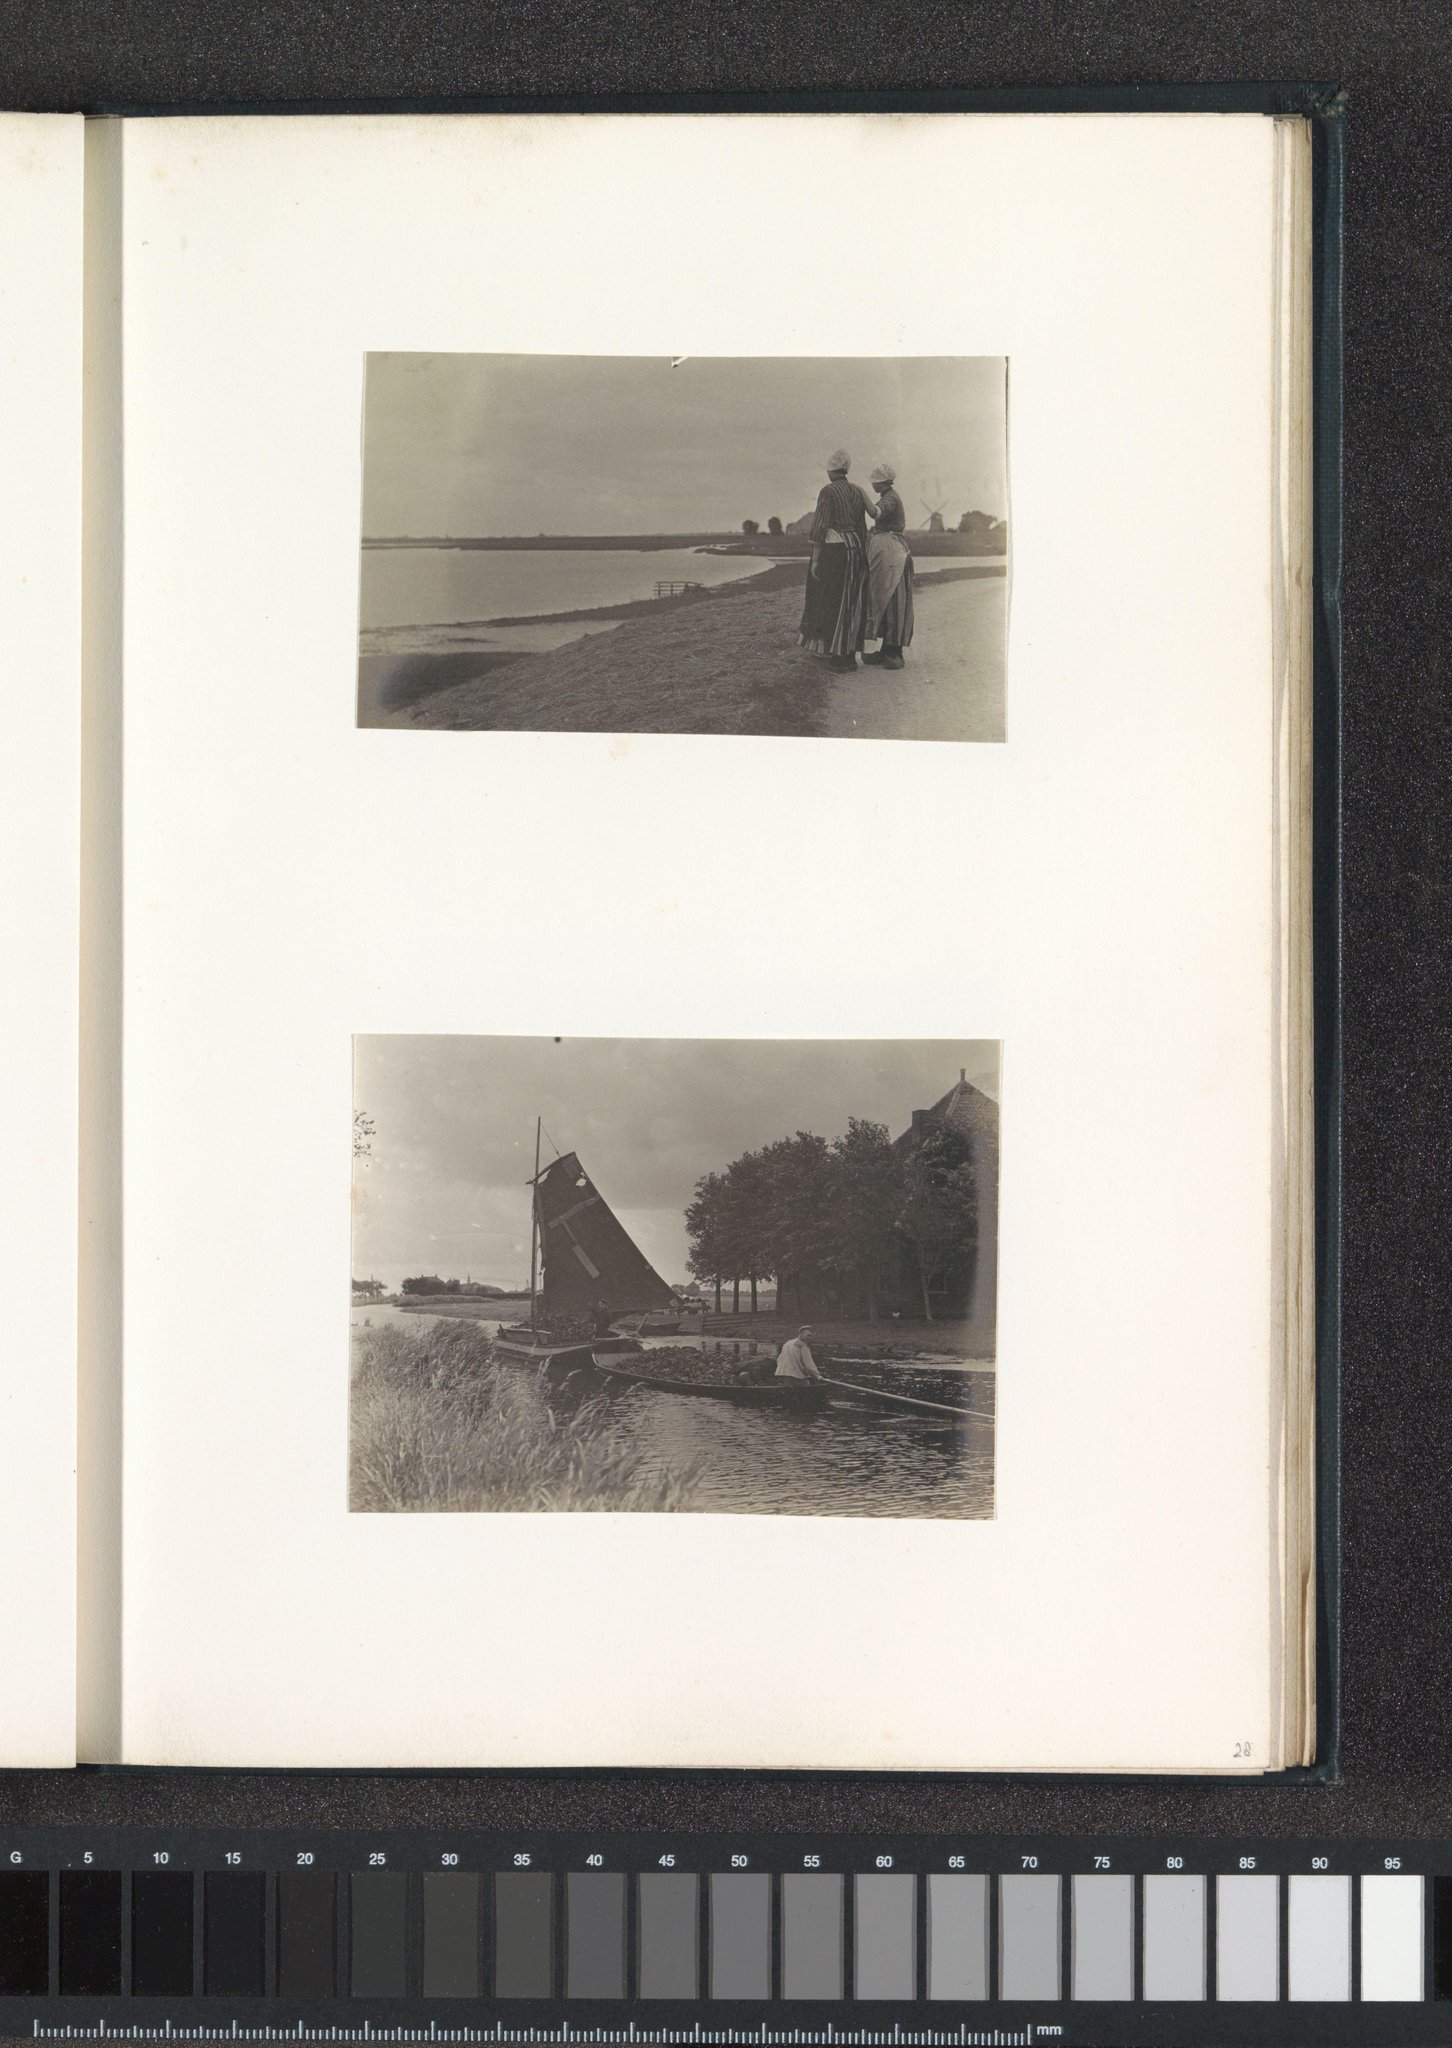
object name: photograph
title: Twee vrouwen in Volendamse klederdracht staand op een dijk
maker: george hidderley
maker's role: fotograaf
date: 1900-1910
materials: paper, photographic support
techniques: gelatin silver print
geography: volendam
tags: folk costume, regional costume (+ women's clothes), dikes, levee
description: Onderdeel van fotoalbum met opnames van Volendam, Dordrecht, Gorinchem en Woudrichem.